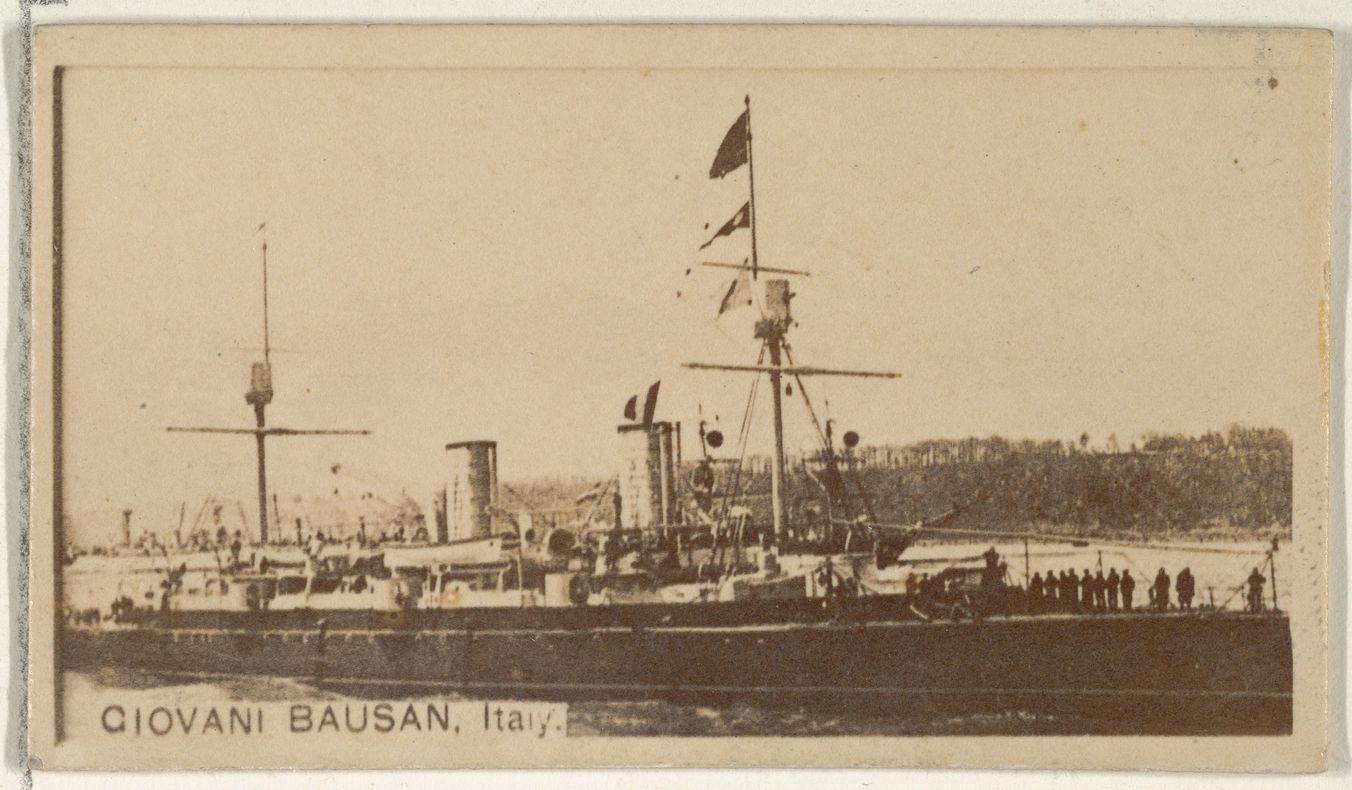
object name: photograph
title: Giovani Bausan, Italy, from the Famous Ships series (N50) for Virginia Brights Cigarettes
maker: allen & ginter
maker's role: publisher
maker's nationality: american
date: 1895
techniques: albumen silver print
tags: ships